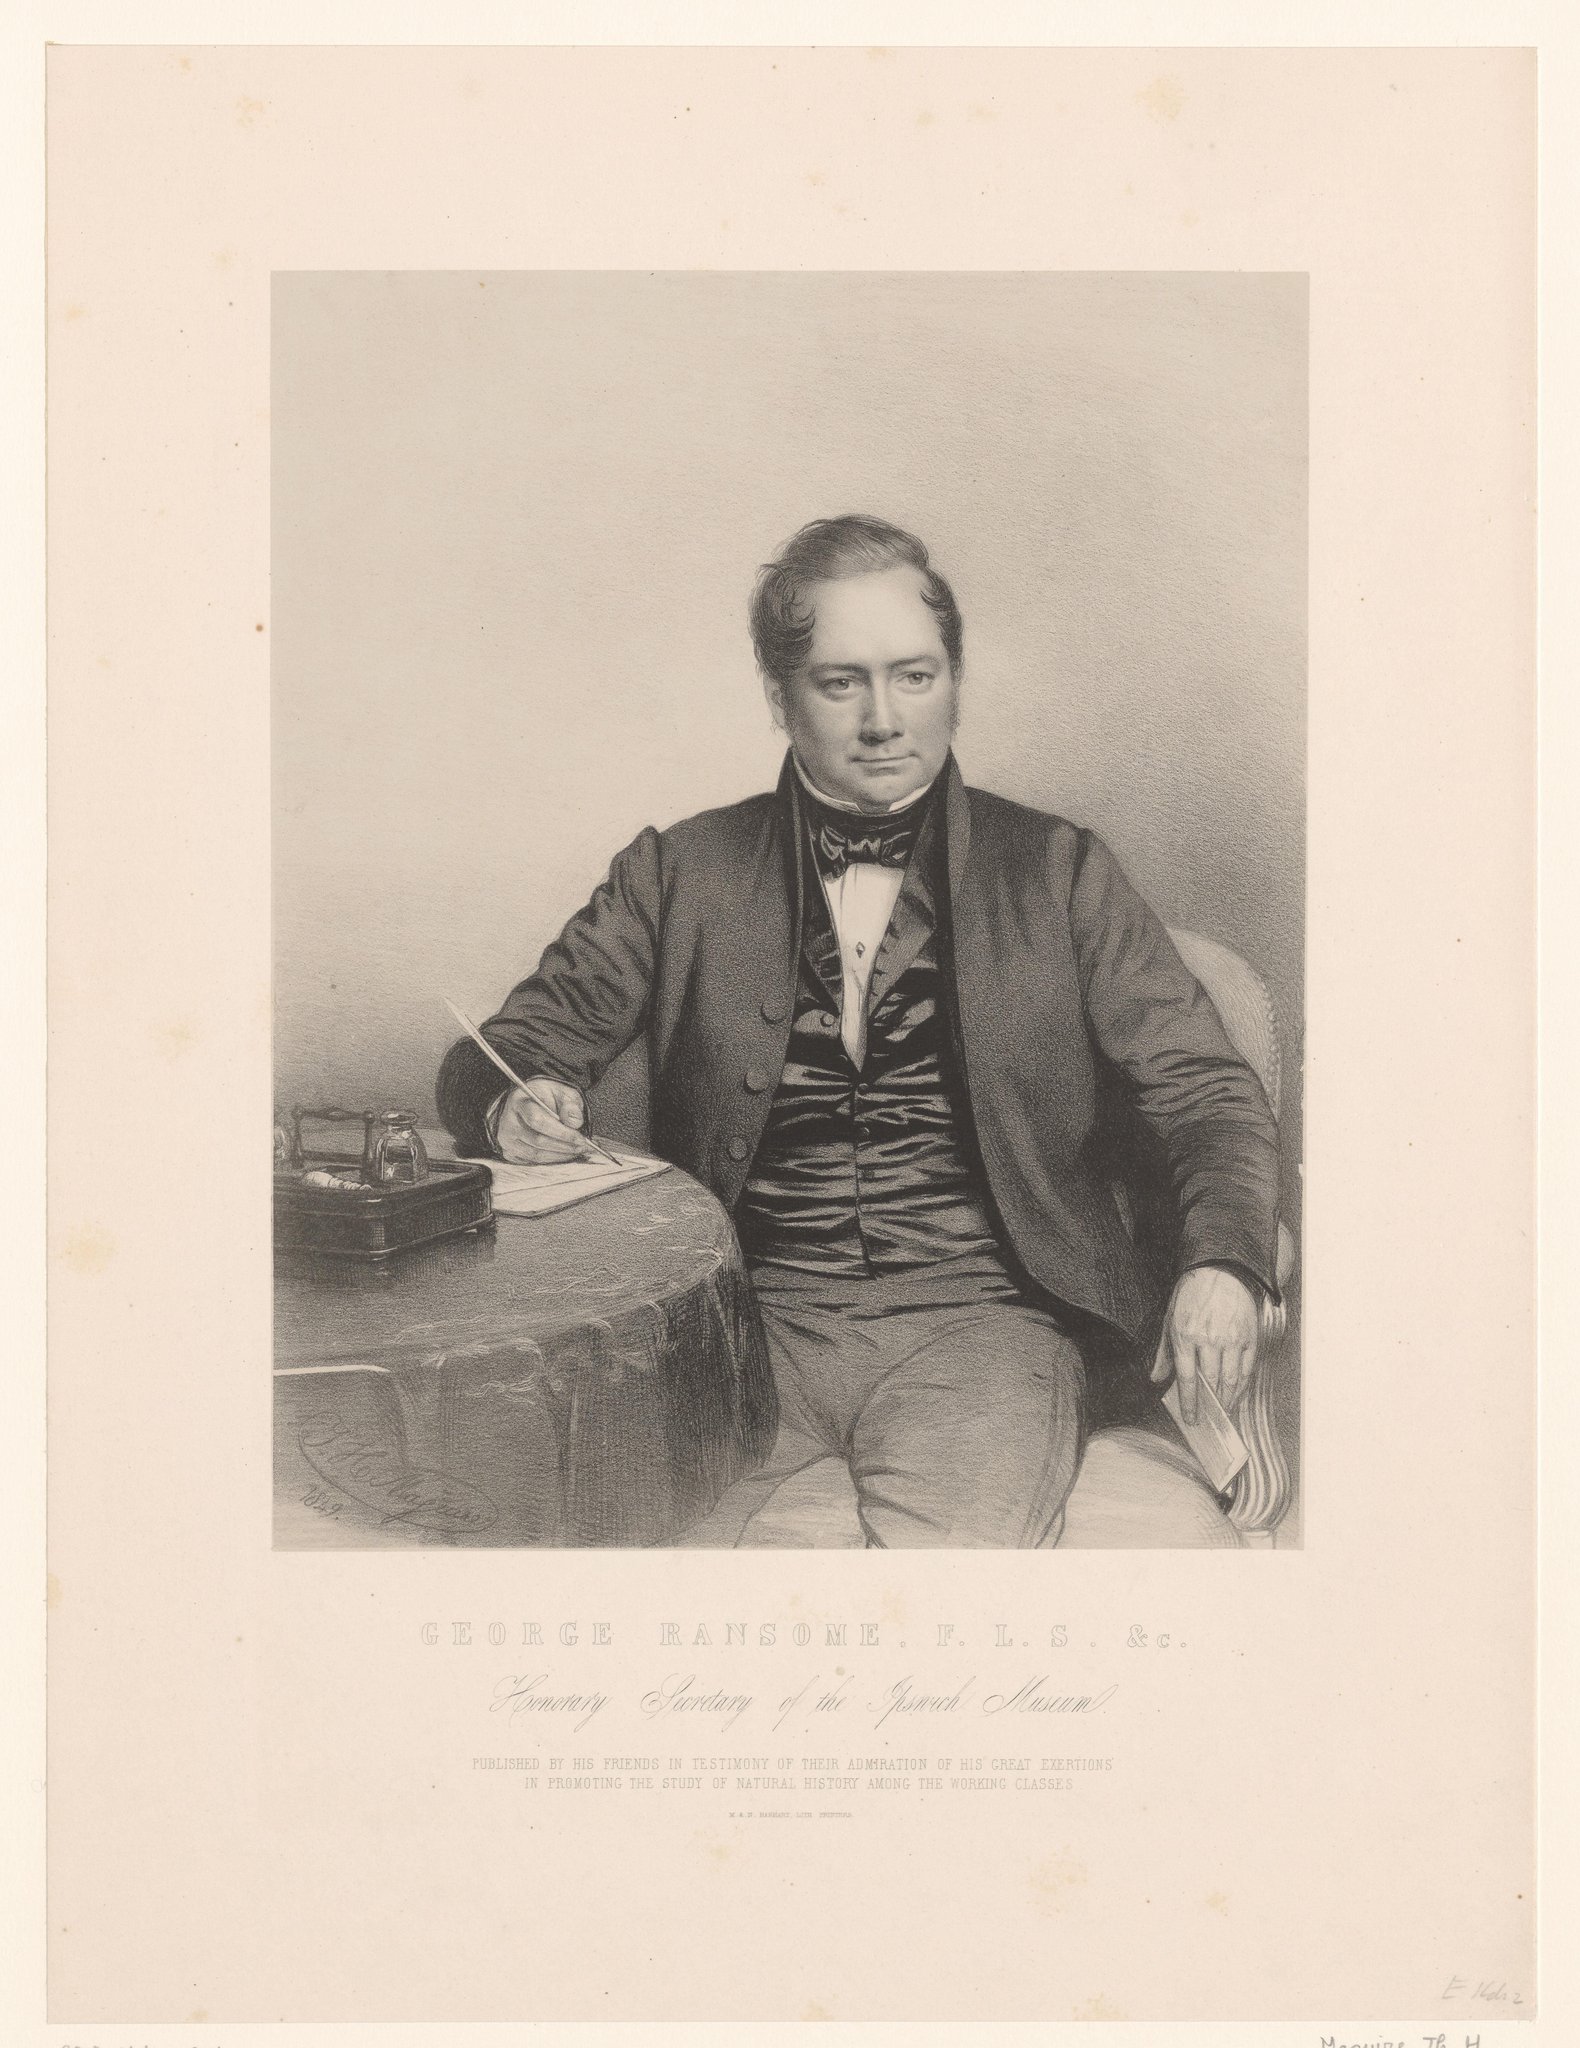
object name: print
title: Portret van George Ransome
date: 1849-1852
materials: paper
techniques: lithograph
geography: london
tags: george ransome, adult man, historical persons, writing and letters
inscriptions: collector's mark: Lugt 2228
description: Prent behoort waarschijnlijk tot de serie 'Ipswich Museum Portraits', ook bekend onder de titel 'Portraits of Honorary Members of the Ipswich Museum'. Deze serie is in 1852 door George Ransome uitgegeven en gedrukt door M&N Hanhart tussen 1848 en 1852. De serie bestaat uit ca. 60 portretten.